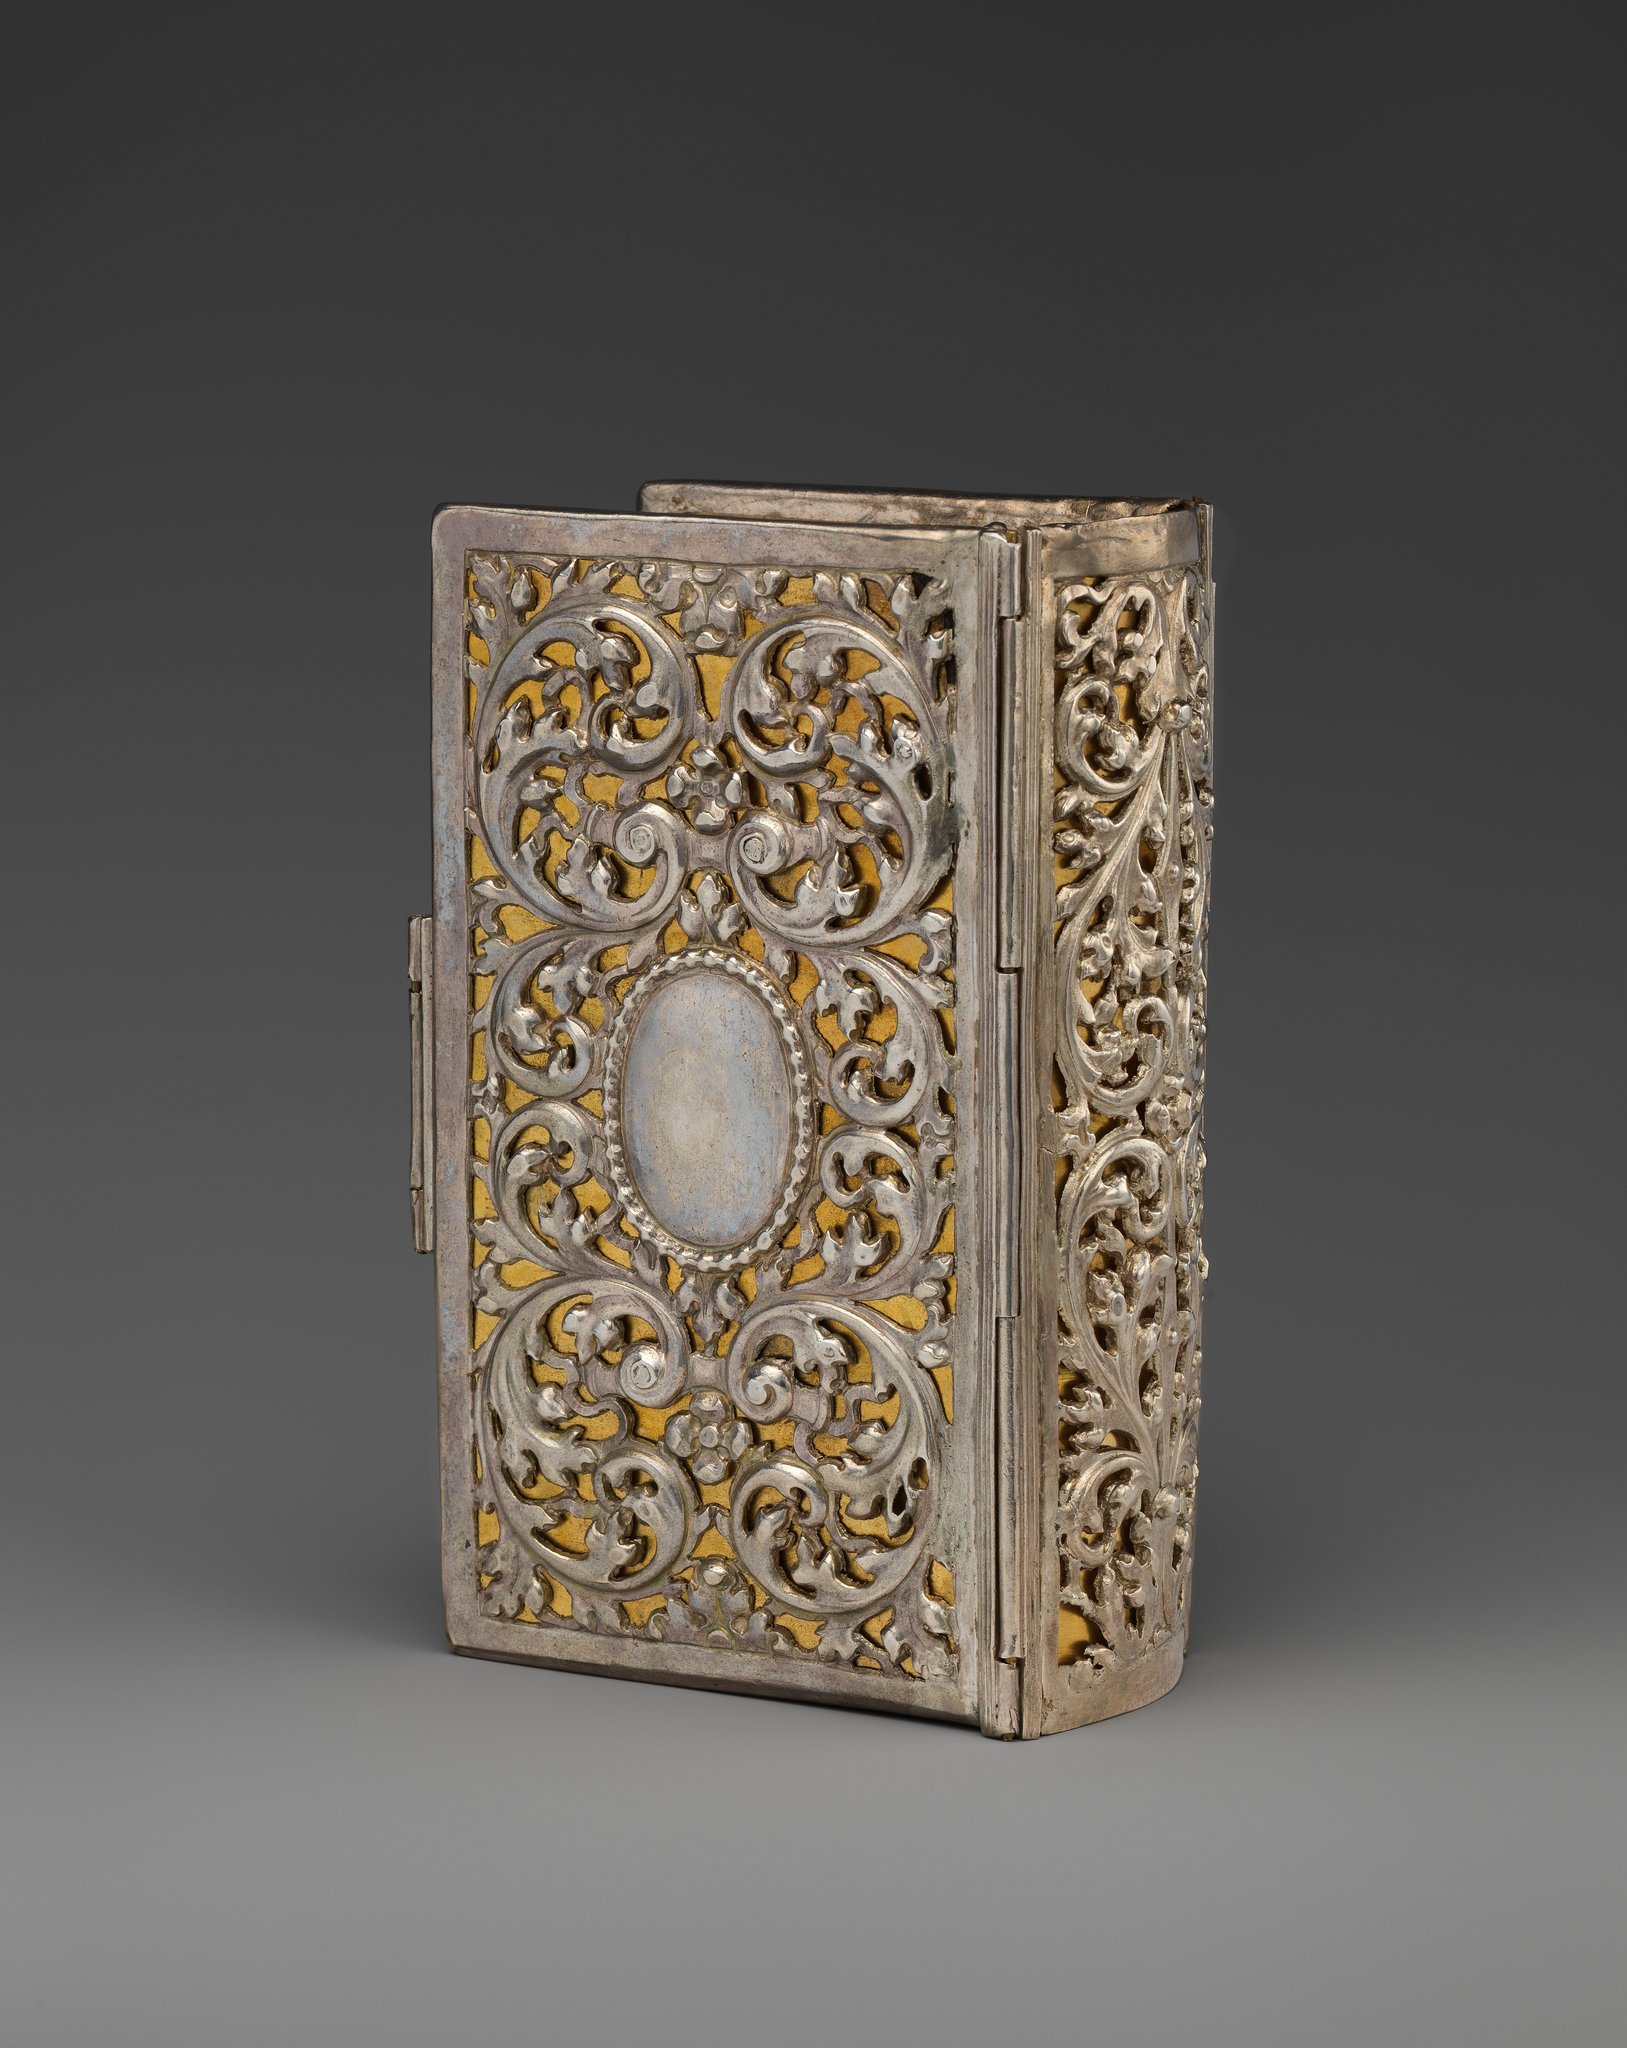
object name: book cover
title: Book cover for Pentateuch and Five Scrolls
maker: tobias schier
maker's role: maker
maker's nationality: polish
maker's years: 1650-1750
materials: gilt, silver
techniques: chasing, embossing